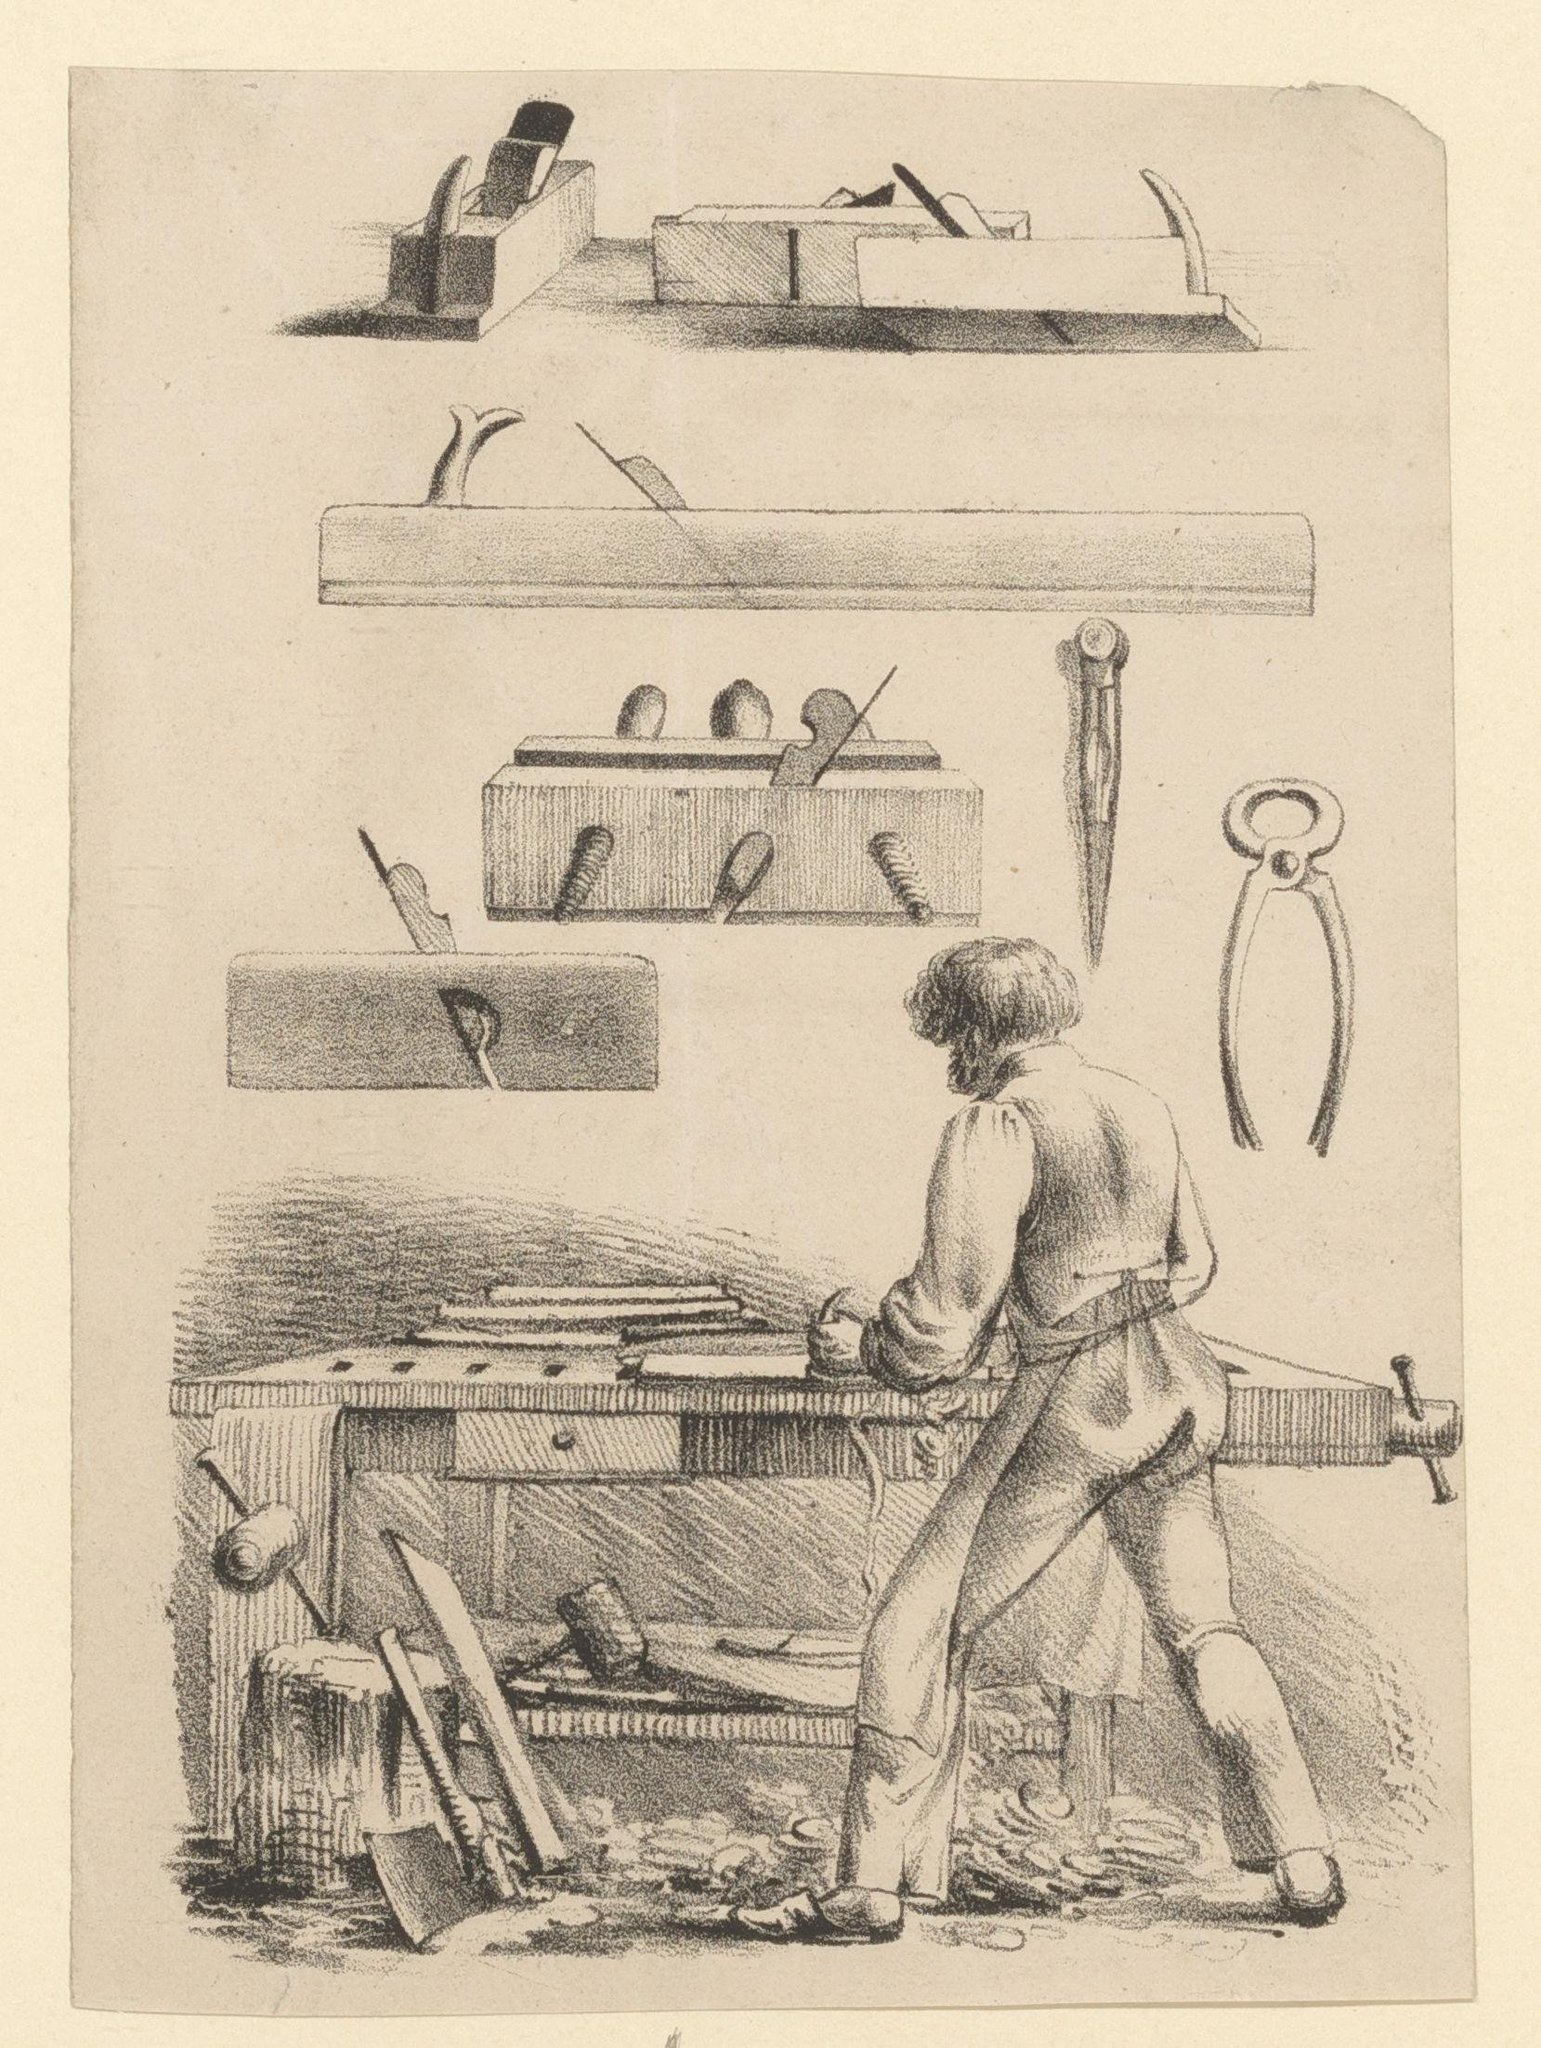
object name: print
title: Timmerman in zijn werkplaats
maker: Anonymous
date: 1800-1899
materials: paper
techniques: lithograph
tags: carpenter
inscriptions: collector's mark: Lugt 1641, stamp, stamp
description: Onderwerpsrubrieken binnen de Atlas Zeden en Gewoonten: Handel, Nijverheid en verkeer, Beroep en bedrijf, Mannelijk, Bewerkers van het hout.